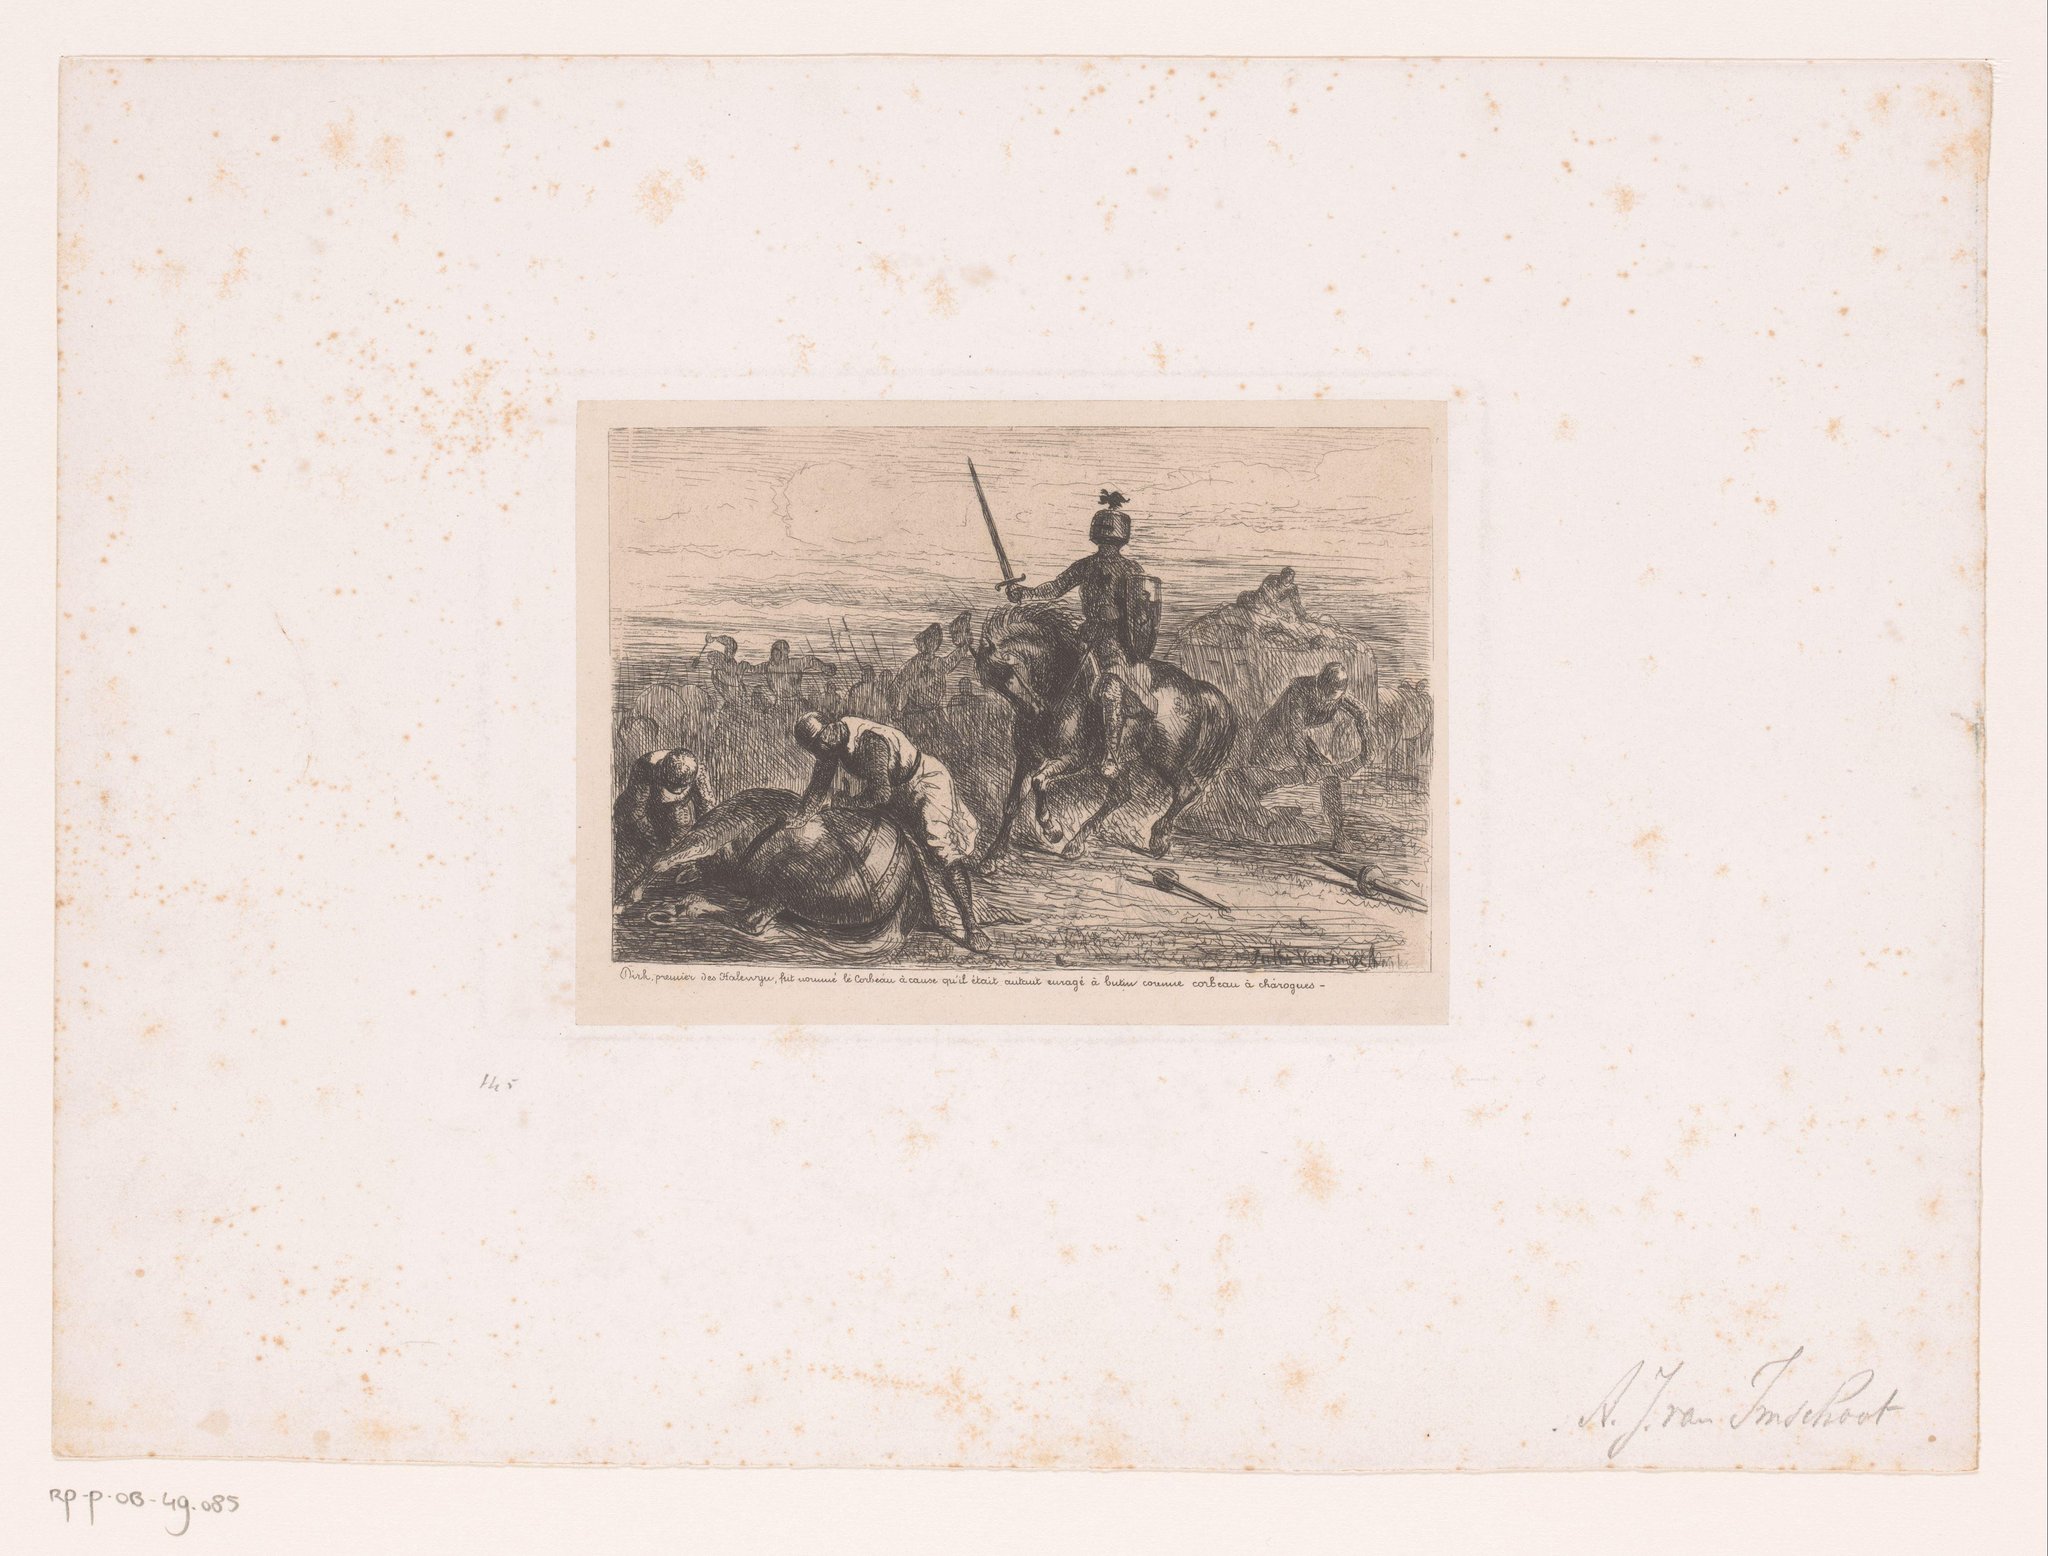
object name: print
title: Dirk, eerste van Halewijn, werd de Raaf genoemd omdat hij even woedend was als een raaf bij aas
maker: jules van imschoot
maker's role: print maker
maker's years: 1821-1884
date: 1831-1884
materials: paper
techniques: etching, intaglio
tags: battle, knight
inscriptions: collector's mark: Lugt 2228